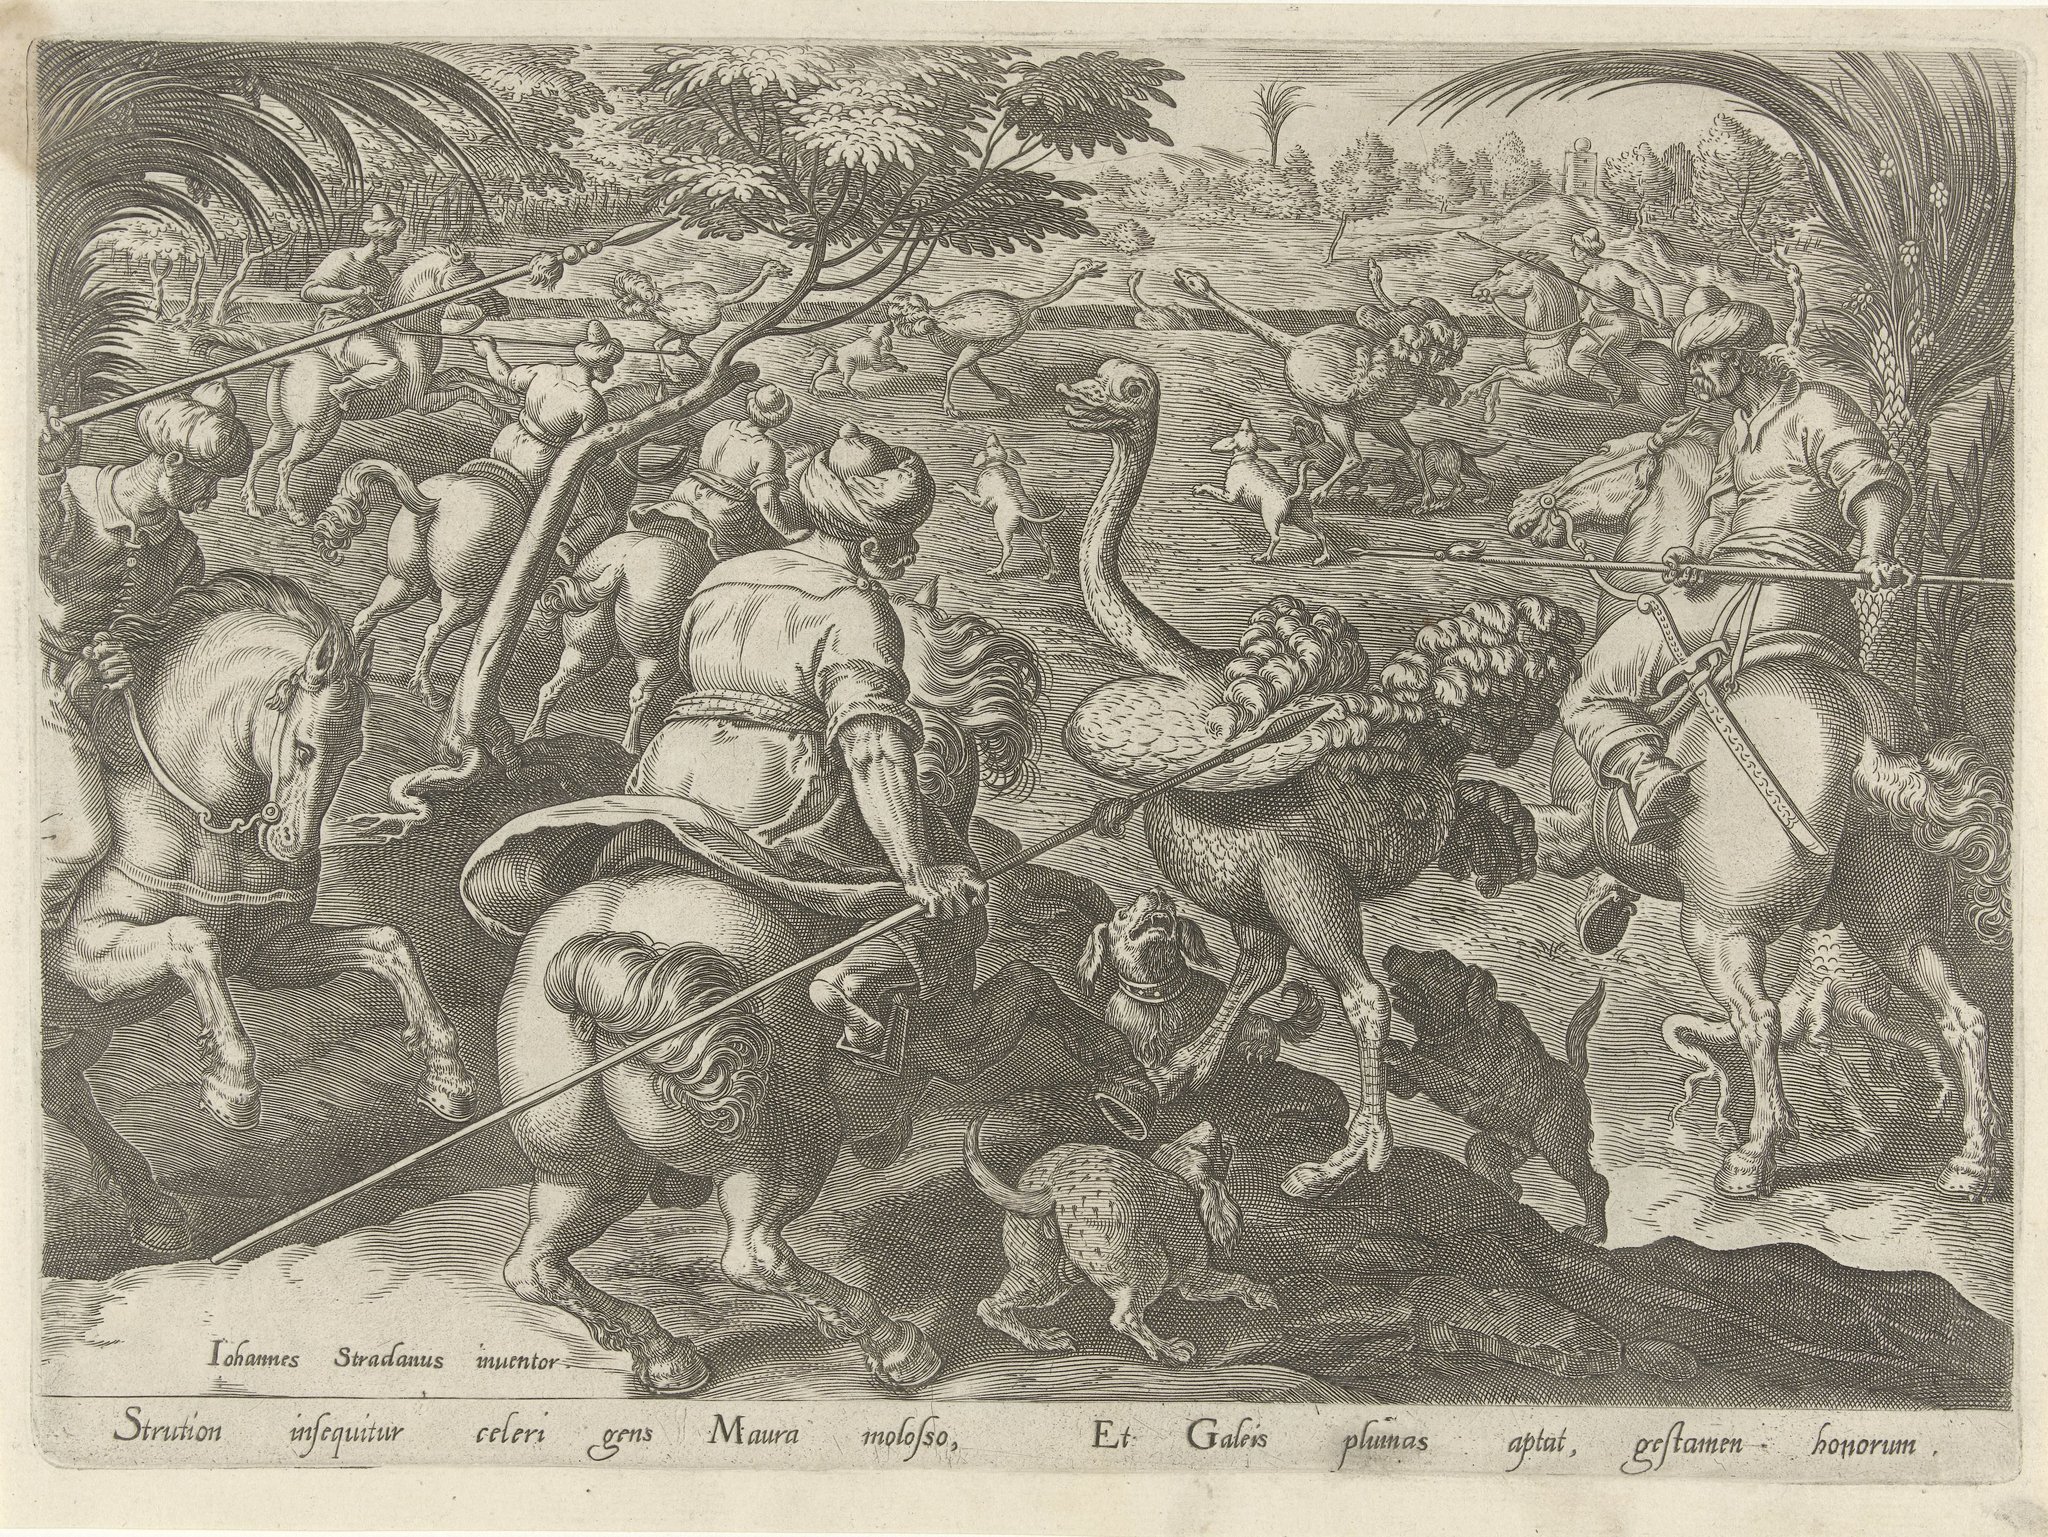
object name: print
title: Jacht op struisvogels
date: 1578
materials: paper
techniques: engraving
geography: antwerp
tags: walker and runner birds: ostrich, bird hunting (+ hunting with horses)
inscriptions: collector's mark: Lugt 2228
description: Ruiters jagen met speren en honden op struisvogels. De prent heeft een Latijns onderschrift en maakt deel uit van een 43-delige serie over de jacht.